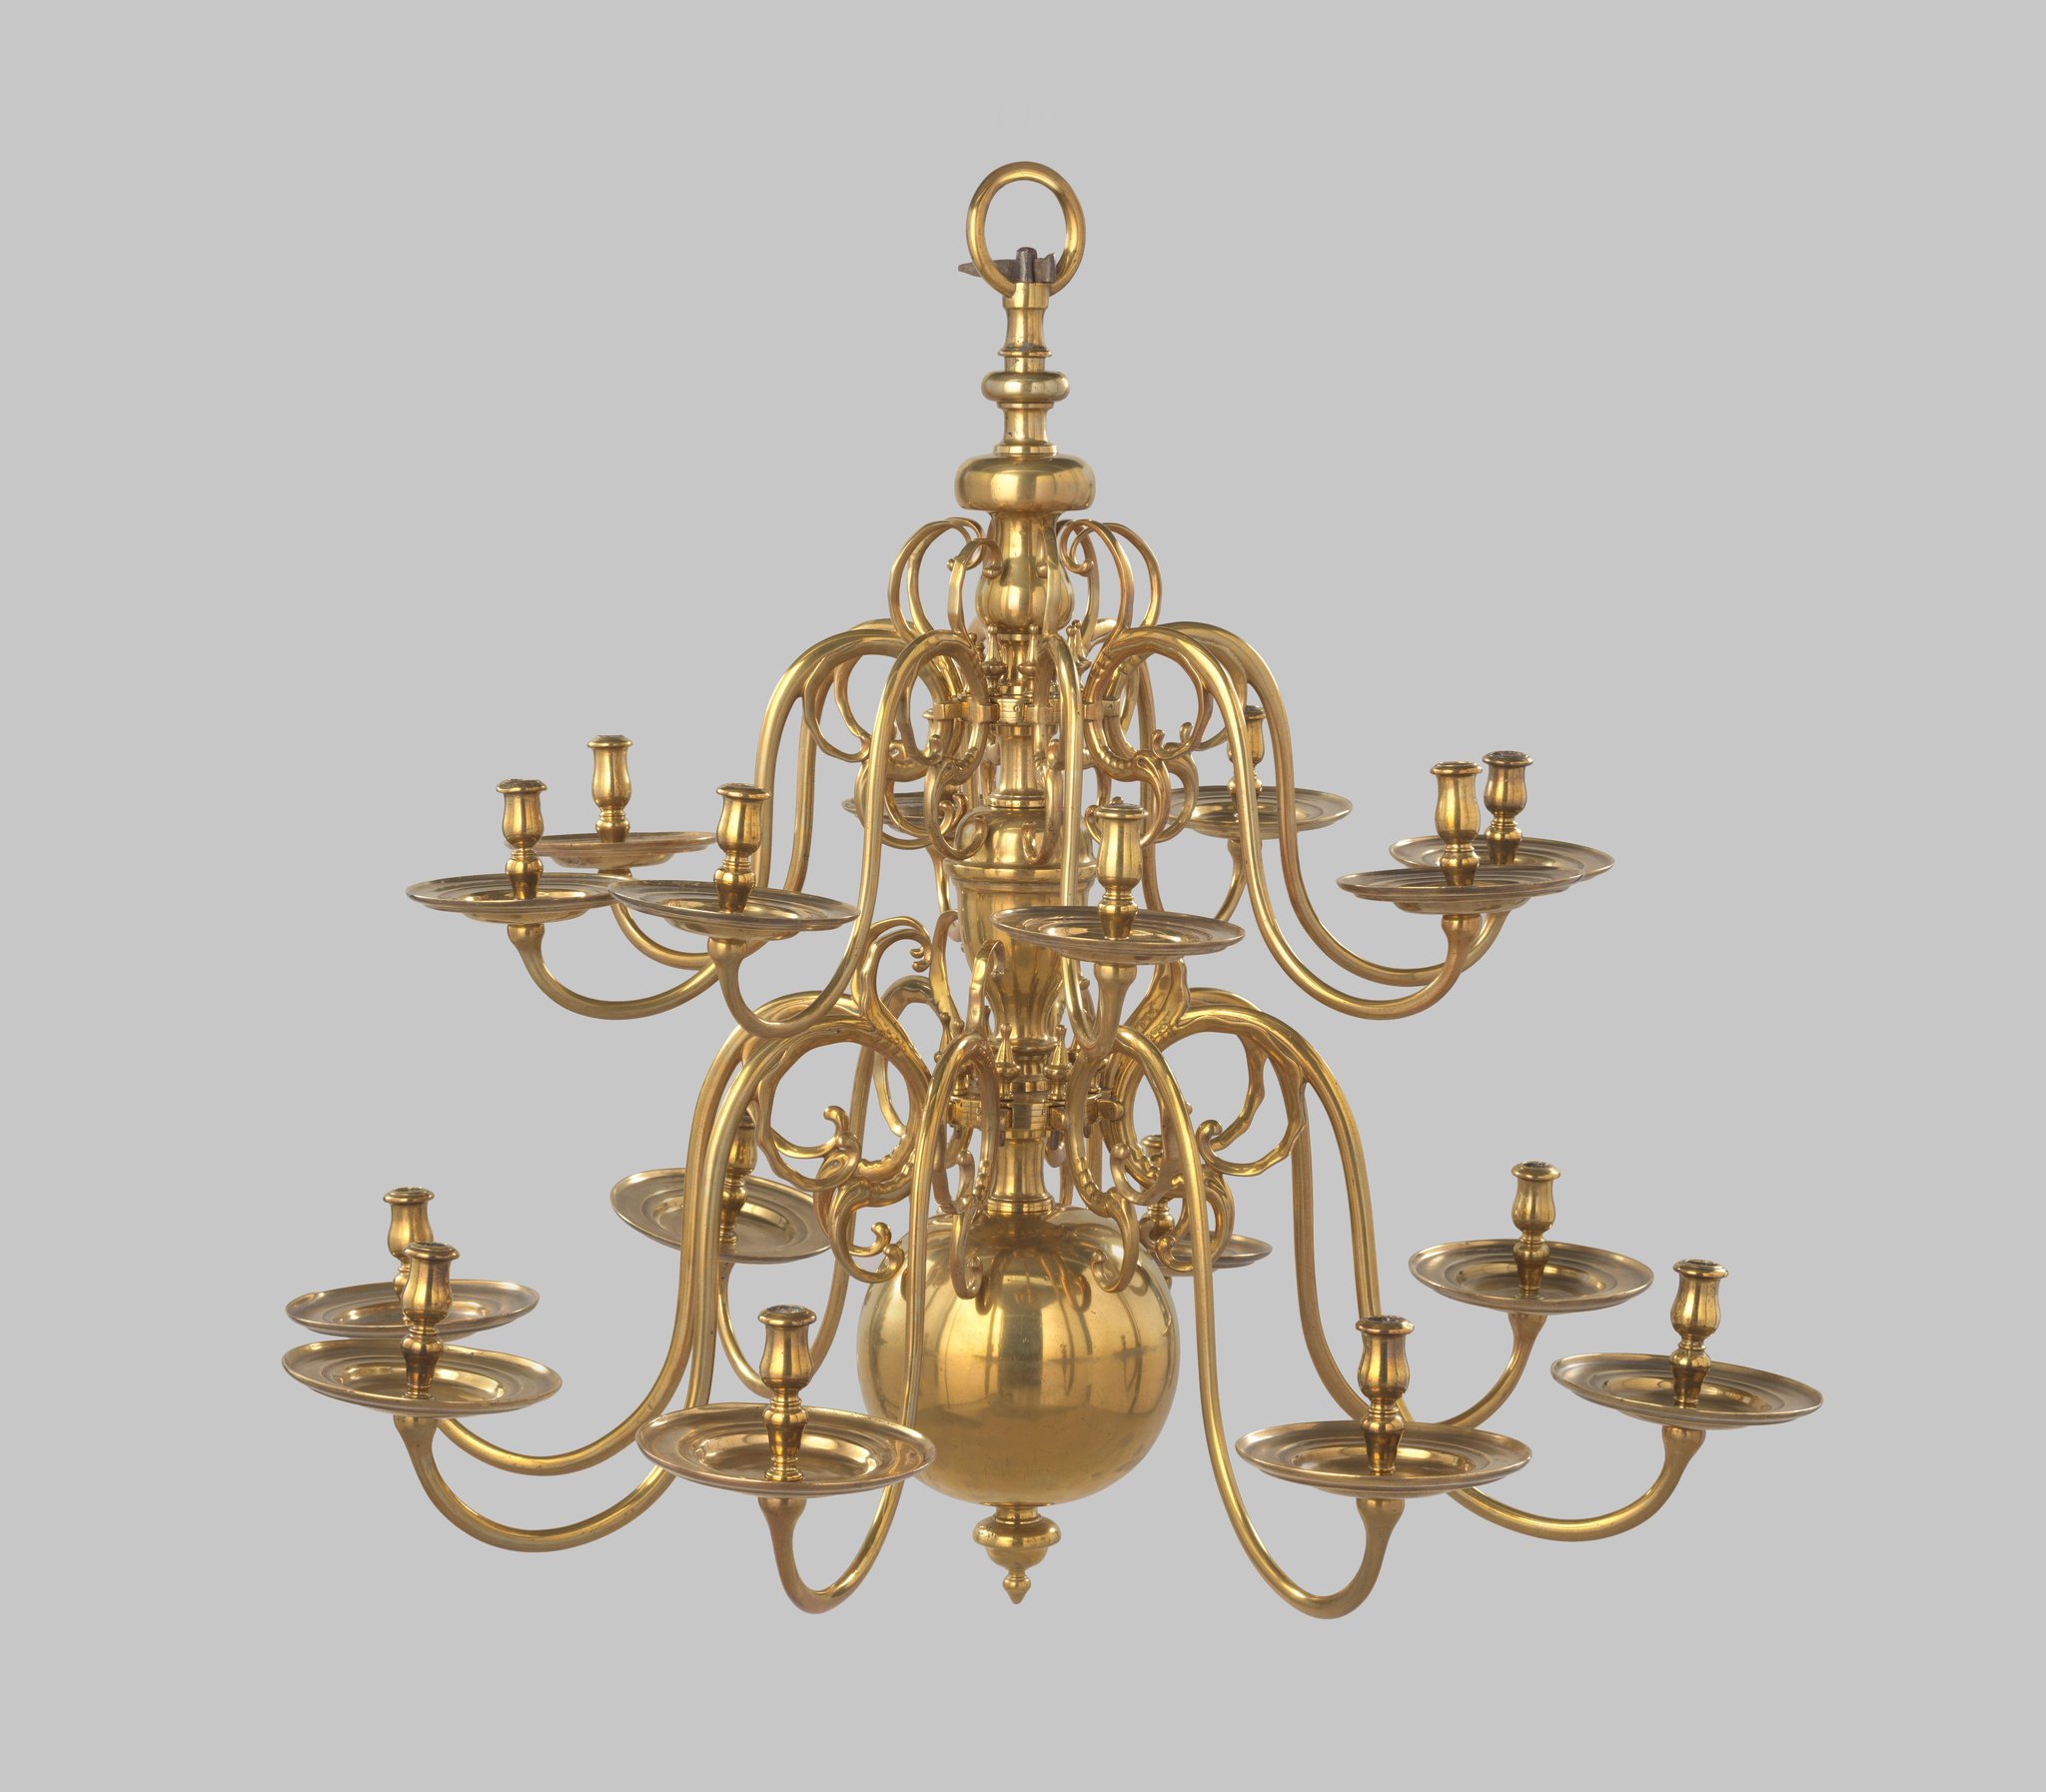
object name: chandelier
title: Arm van een kaarsenkroon in twee hoogten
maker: Anonymous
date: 1650-1675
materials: brass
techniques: screwed, turning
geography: amsterdam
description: De S-vormige arm is aan de stamzijde voorzien van een nok met een opening om deze met een pin in de standring te kunnen vastzetten. Bij de stam is de arm op het eind versierd met een gestileerde dolfijnenkop en met twee krullen, waarvan de vormgeving aan het kwabornament is ontleend. Naar buiten toe eindigt de arm in een verdikking, waarin een van een schroefdraad voorzien gat is aangebracht ter bevestiging van de kaarsenhouder met de vetvanger. De arm is met behulp van hetzelfde model gegoten als de overige armen van de krans en heeft dezelfe grootte. De kaarsenhouder heeft een ronde zich naar boven toe versmallende en in een uitstekende rand overgaande vaasvorm op balustervoet met een van een schroefdraad voorzien eind, waarin onderaan het centergat. De vetvanger is aan de bovenkant naar het midden toe één keer verdiept. Aan de onderkant is zij geprofileerd op de rand en rond het gat op het enigszins bolvormige midden. De vetvanger heeft telkens zijn eigen grootte en is met behulp van hetzelfde model gegoten als de overige vetvangers van deze krans. De pin is voorzien van een knop in vaasvorm. Dit is de tweede arm van de onderste standring, genummerd op de nok met de letter B.